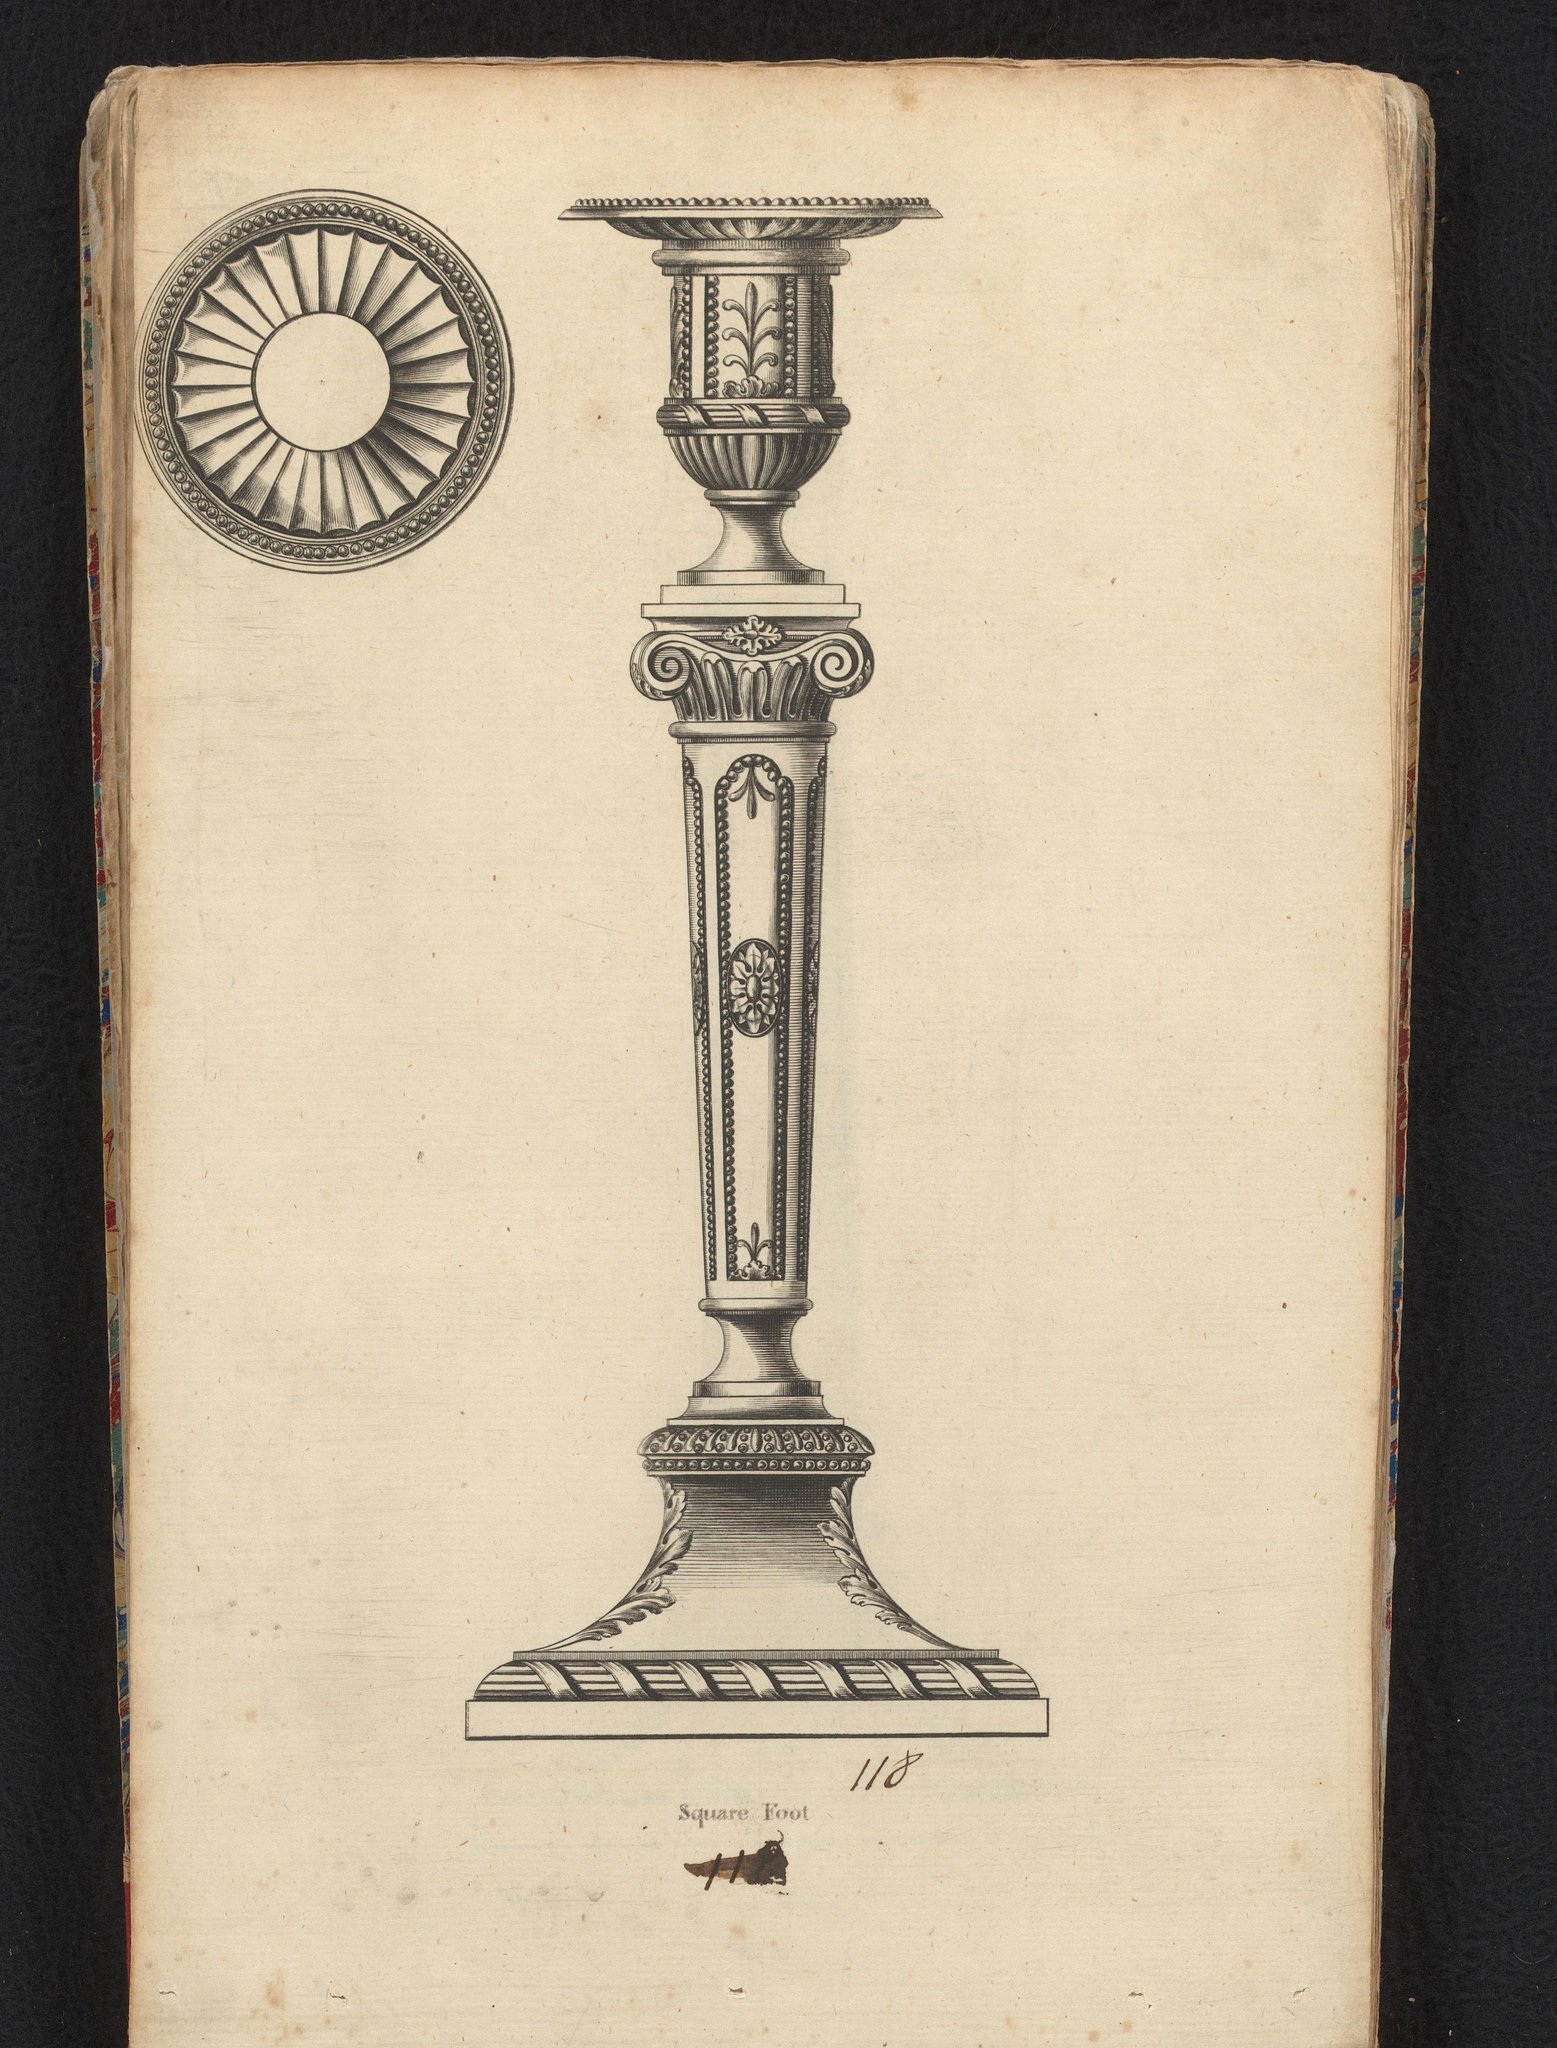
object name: ornament print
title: Ontwerp voor een kandelaar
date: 1784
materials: paper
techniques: engraving, etching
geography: england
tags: candlestick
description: Ontwerp voor een kandelaar met een ronde voet, op het volle blad. Met detail van de voet. Met gedrukt onderschrift en handgeschreven nr. 118. Onderdeel van een catalogus met assortiment modellen van Sheffield verzilverd vaatwerk (pleet) door Matthew Boulton.